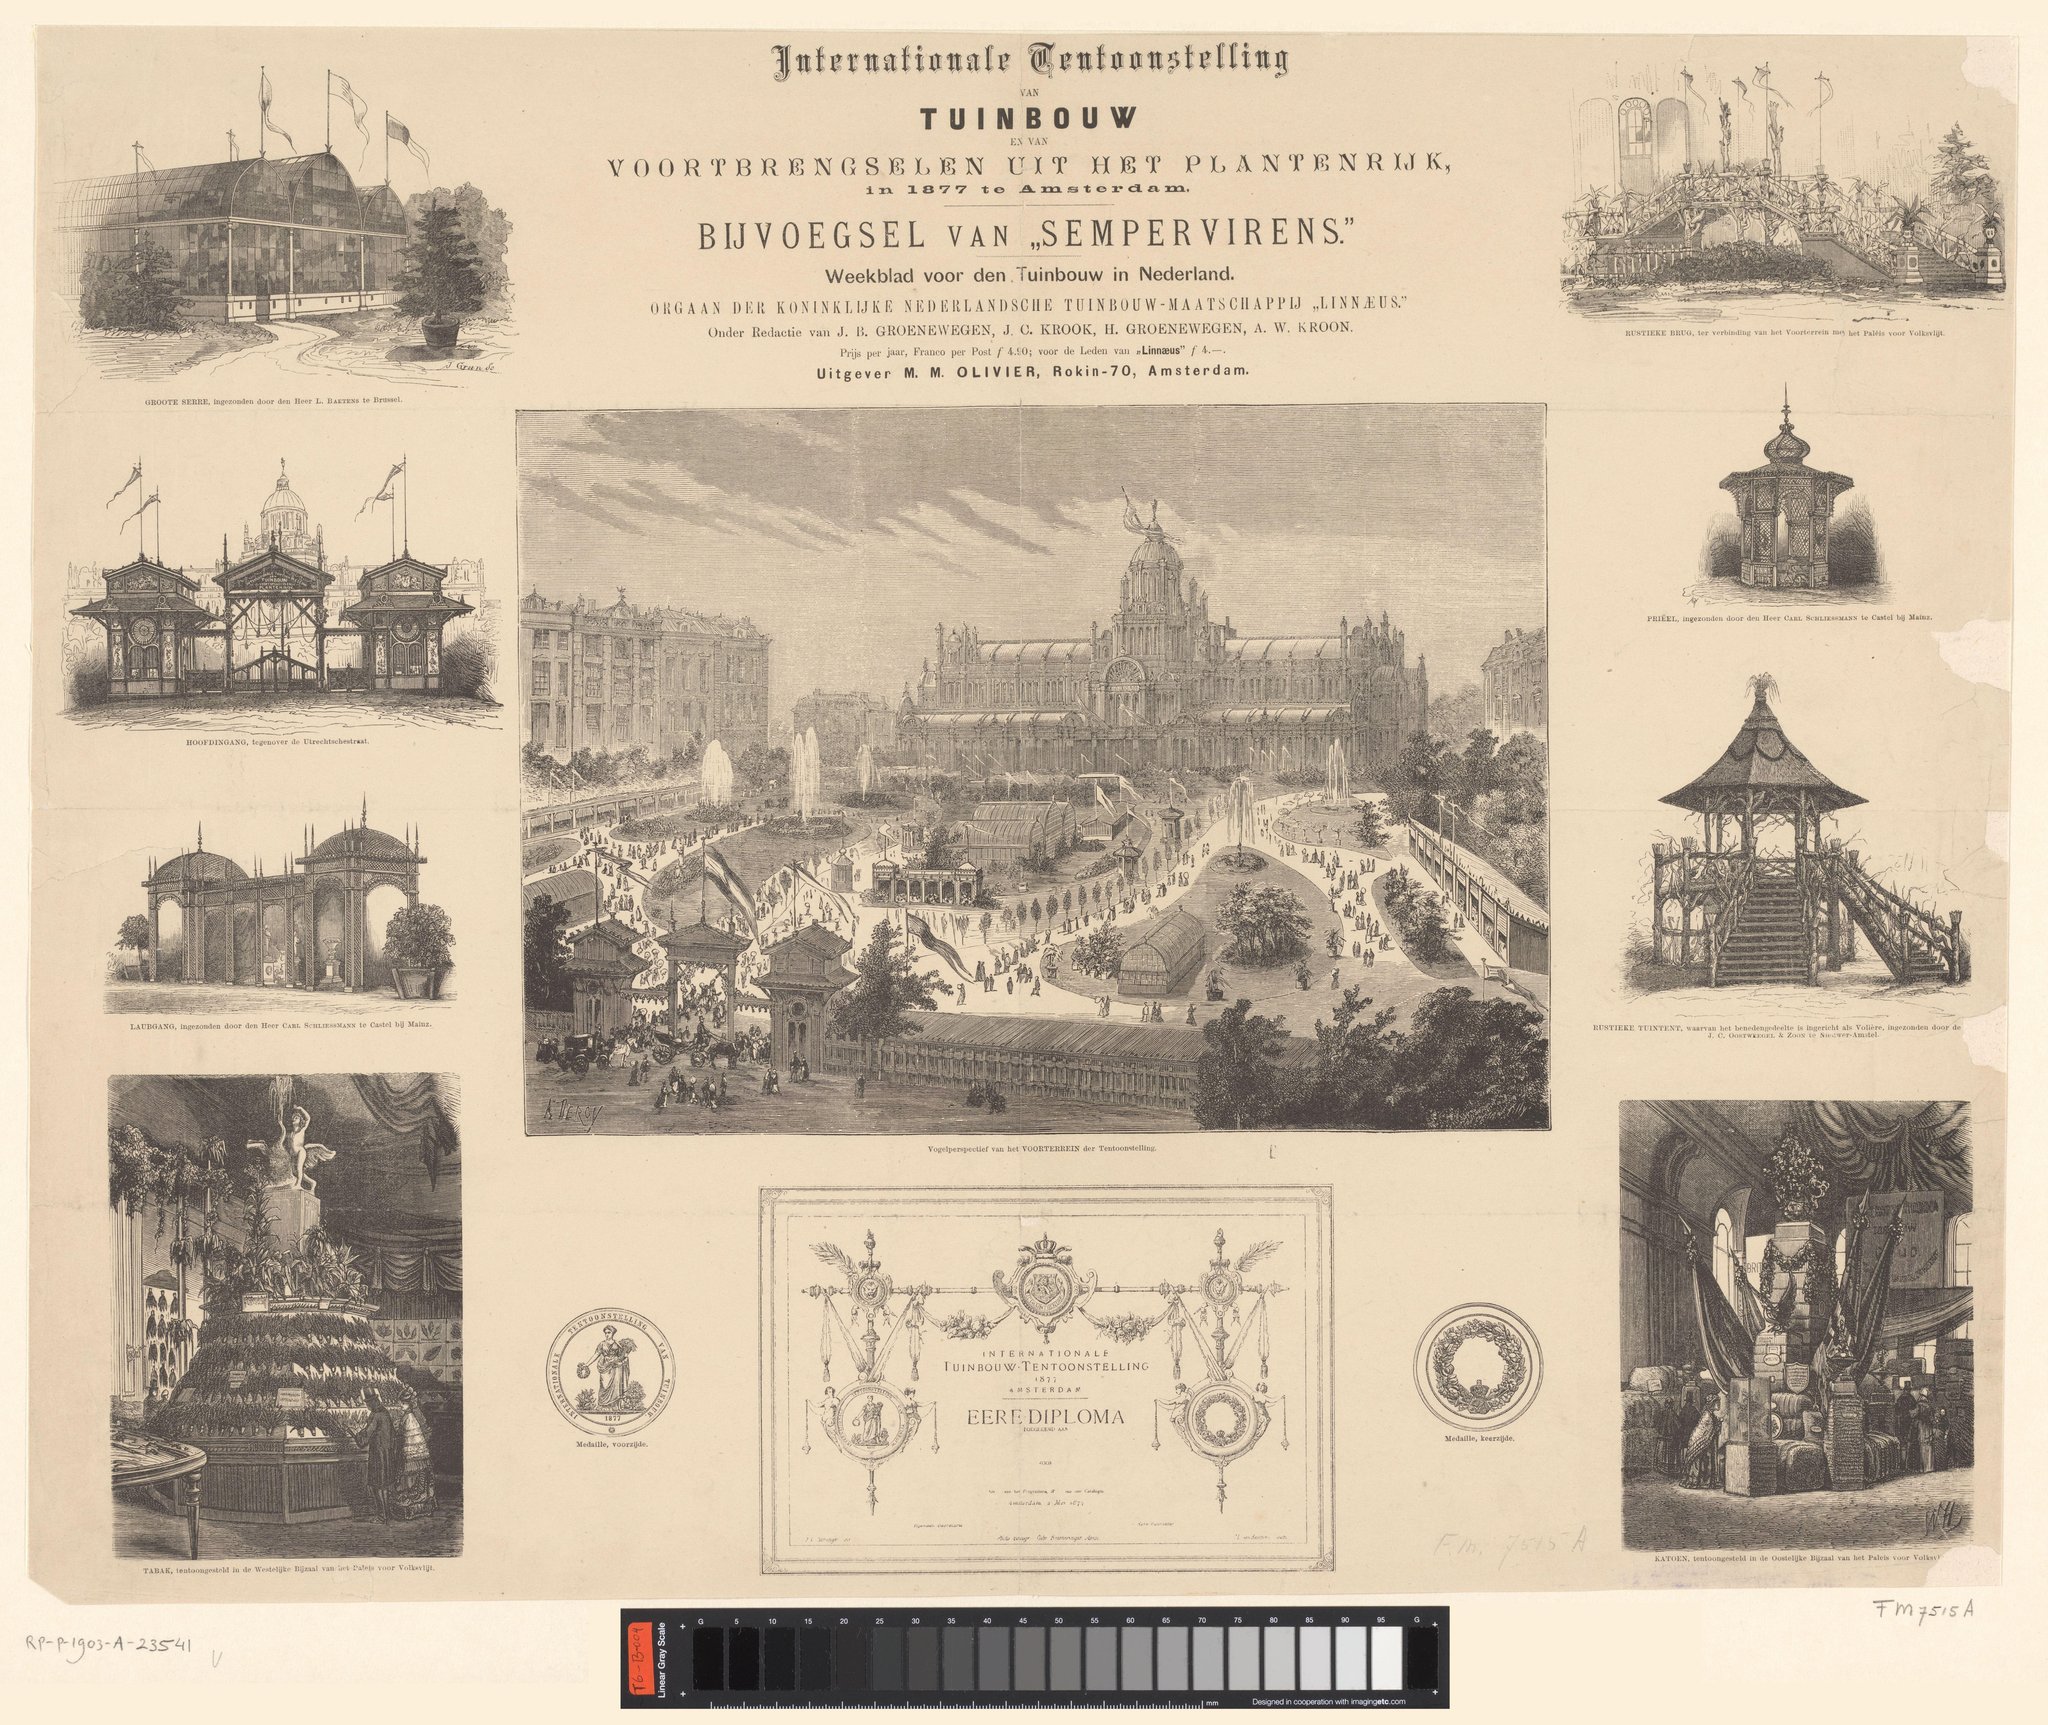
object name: print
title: Internationale Tentoonstelling van Tuinbouw en van voortbrengselen uit het Plantenrijk, in 1877 te Amsterdam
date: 1877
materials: paper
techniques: lithograph, engraving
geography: amsterdam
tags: cultivation of (ornamental) garden, trade exhibition, industries fair, gardening, cultivation ~ agriculture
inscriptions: collector's mark: Lugt 2228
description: Gezicht op het Paleis voor Volksvlijt te Amsterdam met op het voorterrein de gebouwen van de Tentoonstelling van Tuinbouw, 1877. Aan elke zijde vier van de aparte gebouwen op de tentoonstelling. Onderaan de erediploma uitgereikt op de tentoonstelling. Dit blad gepubliceerd als bijvoegsel van "Sempervirens", het weekblad voor tuinbouw in Nederland, het orgaan van de Koninklijke Nederlandsche tuinbouw-maatschappij Linnaeus.